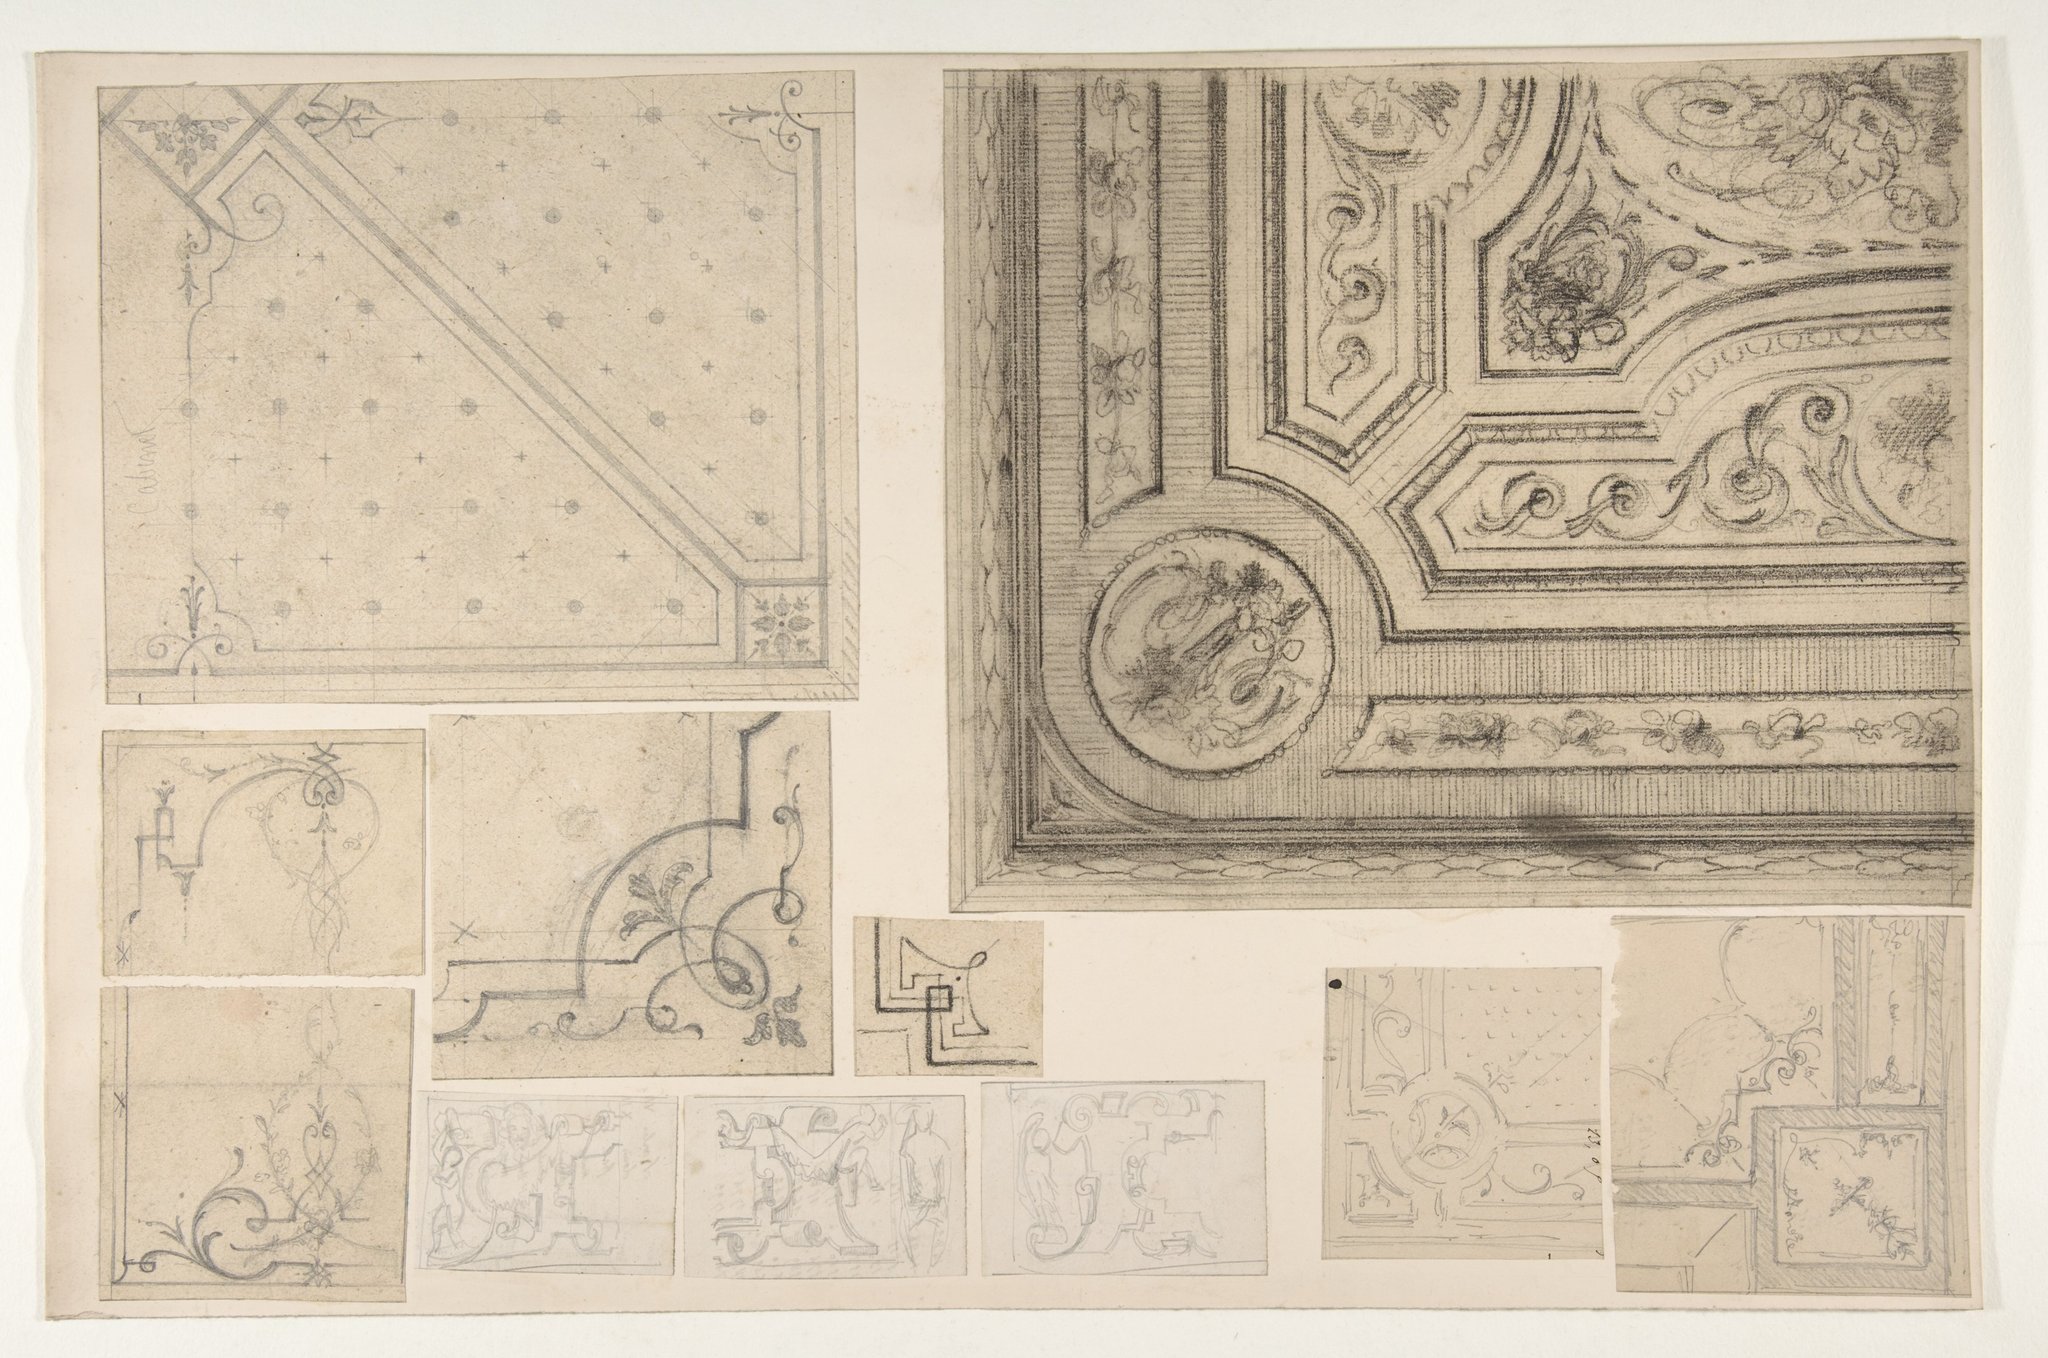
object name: drawing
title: Eleven designs for the decoration of interiors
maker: jules-edmond-charles lachaise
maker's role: artist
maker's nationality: french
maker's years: 1897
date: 1830-1897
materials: cardboard, chalk, graphite, paper